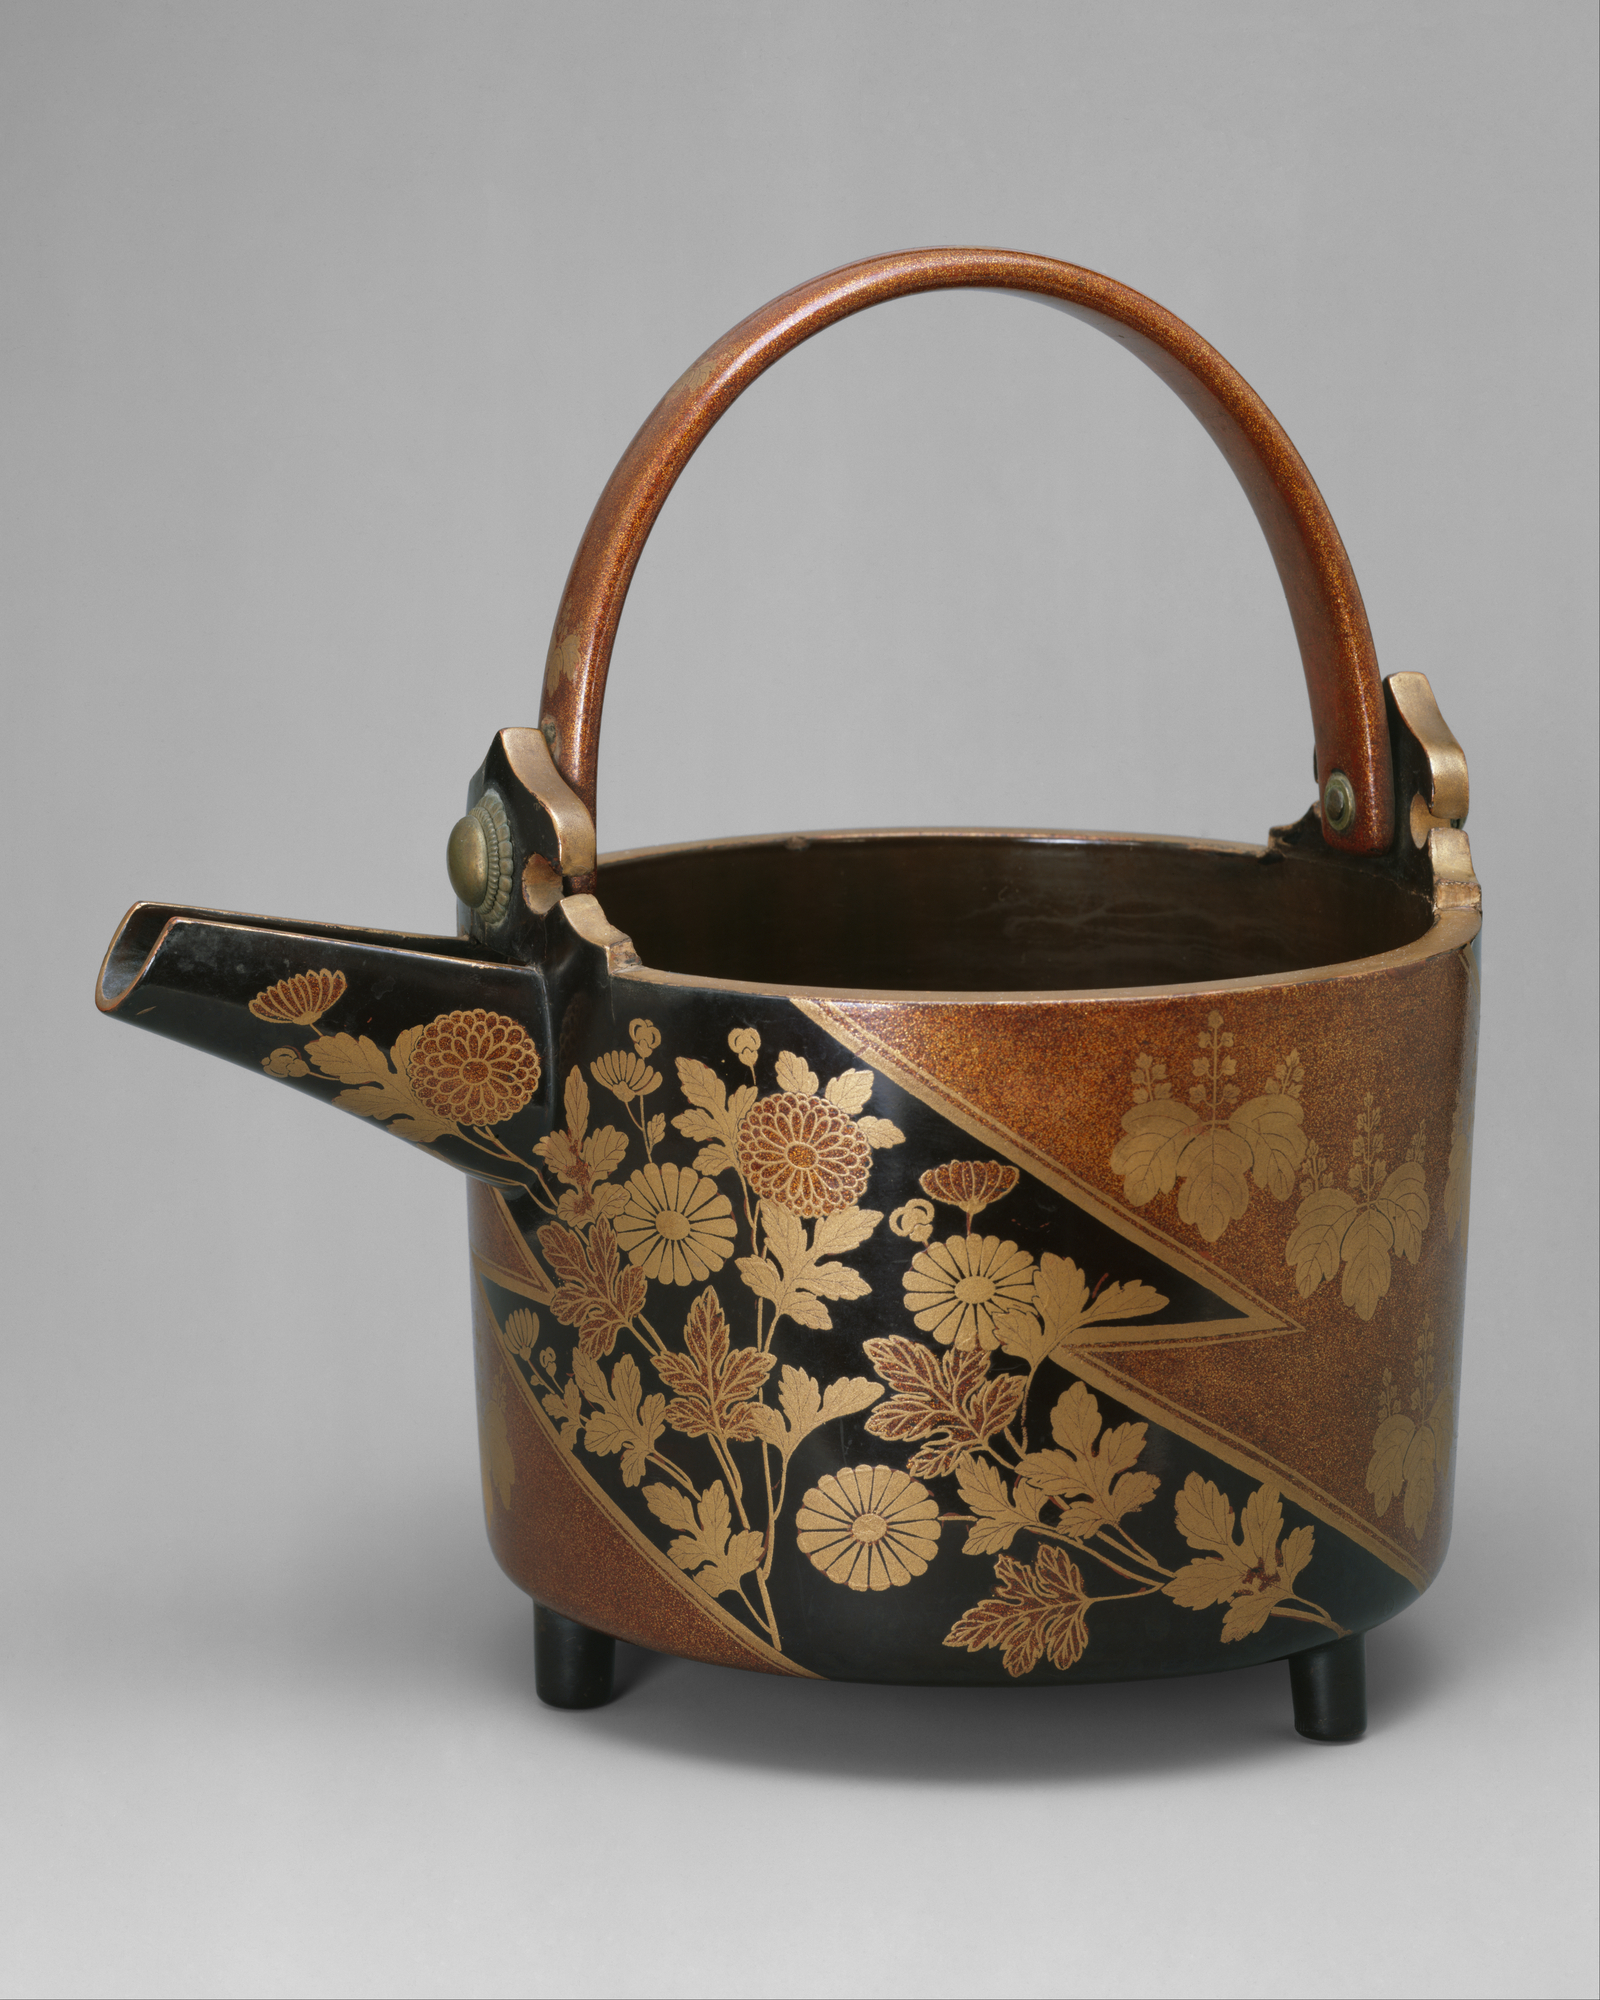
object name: wine ewer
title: Sake Ewer (Hisage) with Chrysanthemums and Paulownia Crests in Alternating Fields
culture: japanese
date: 1601-1633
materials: gold, wood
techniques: hiramakie, lacquer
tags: flowers